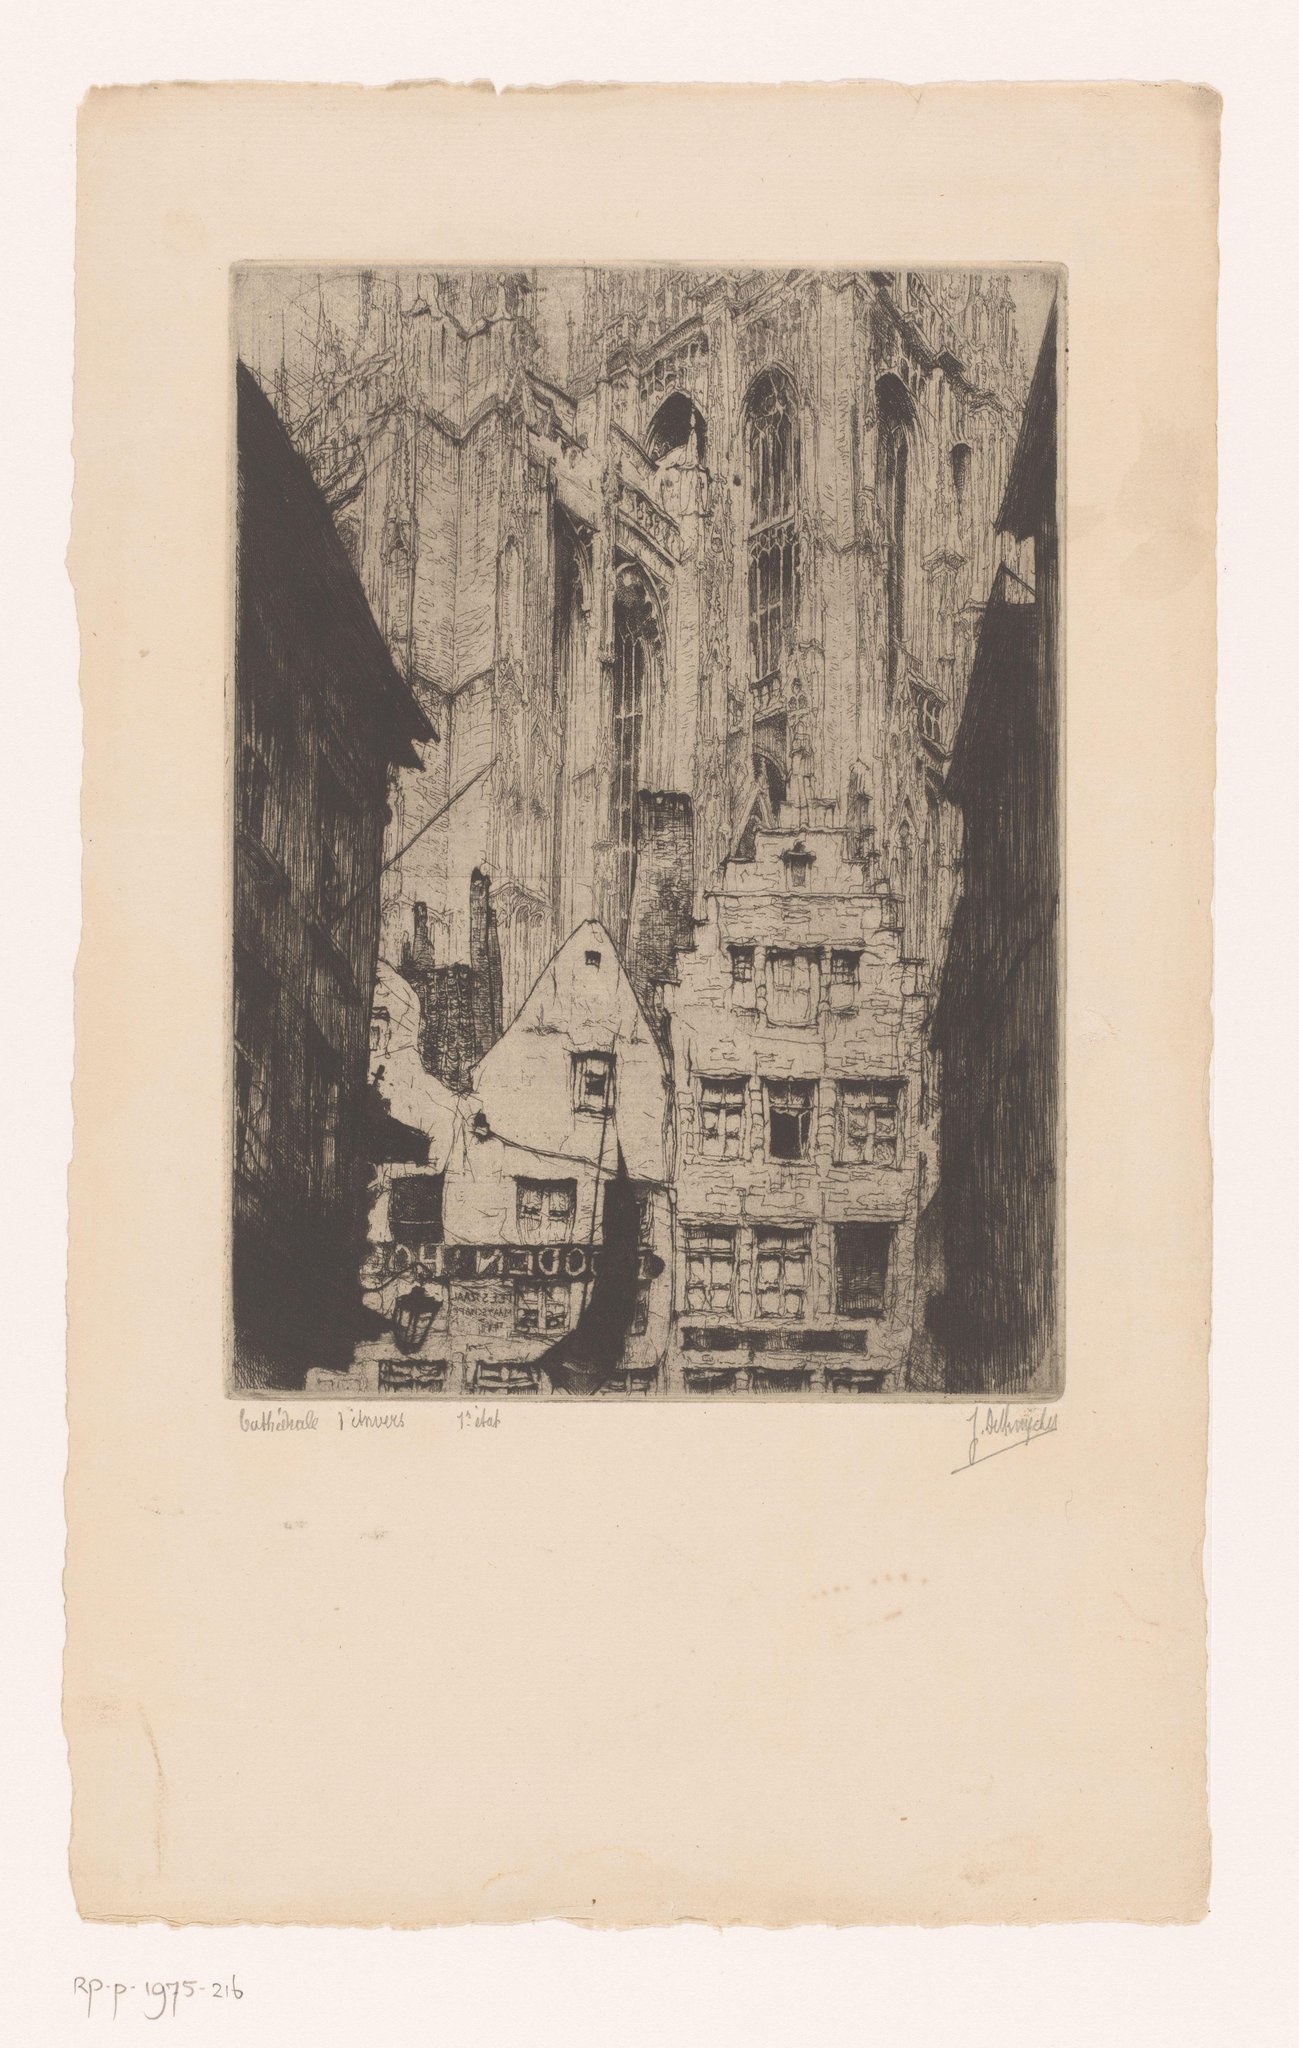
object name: print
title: Gezicht op de kathedraal van Antwerpen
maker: jules de bruycker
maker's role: print maker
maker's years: 1870-1945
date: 1929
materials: paper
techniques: drypoint, etching, intaglio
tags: church (exterior)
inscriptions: annotation: ‘1e état’